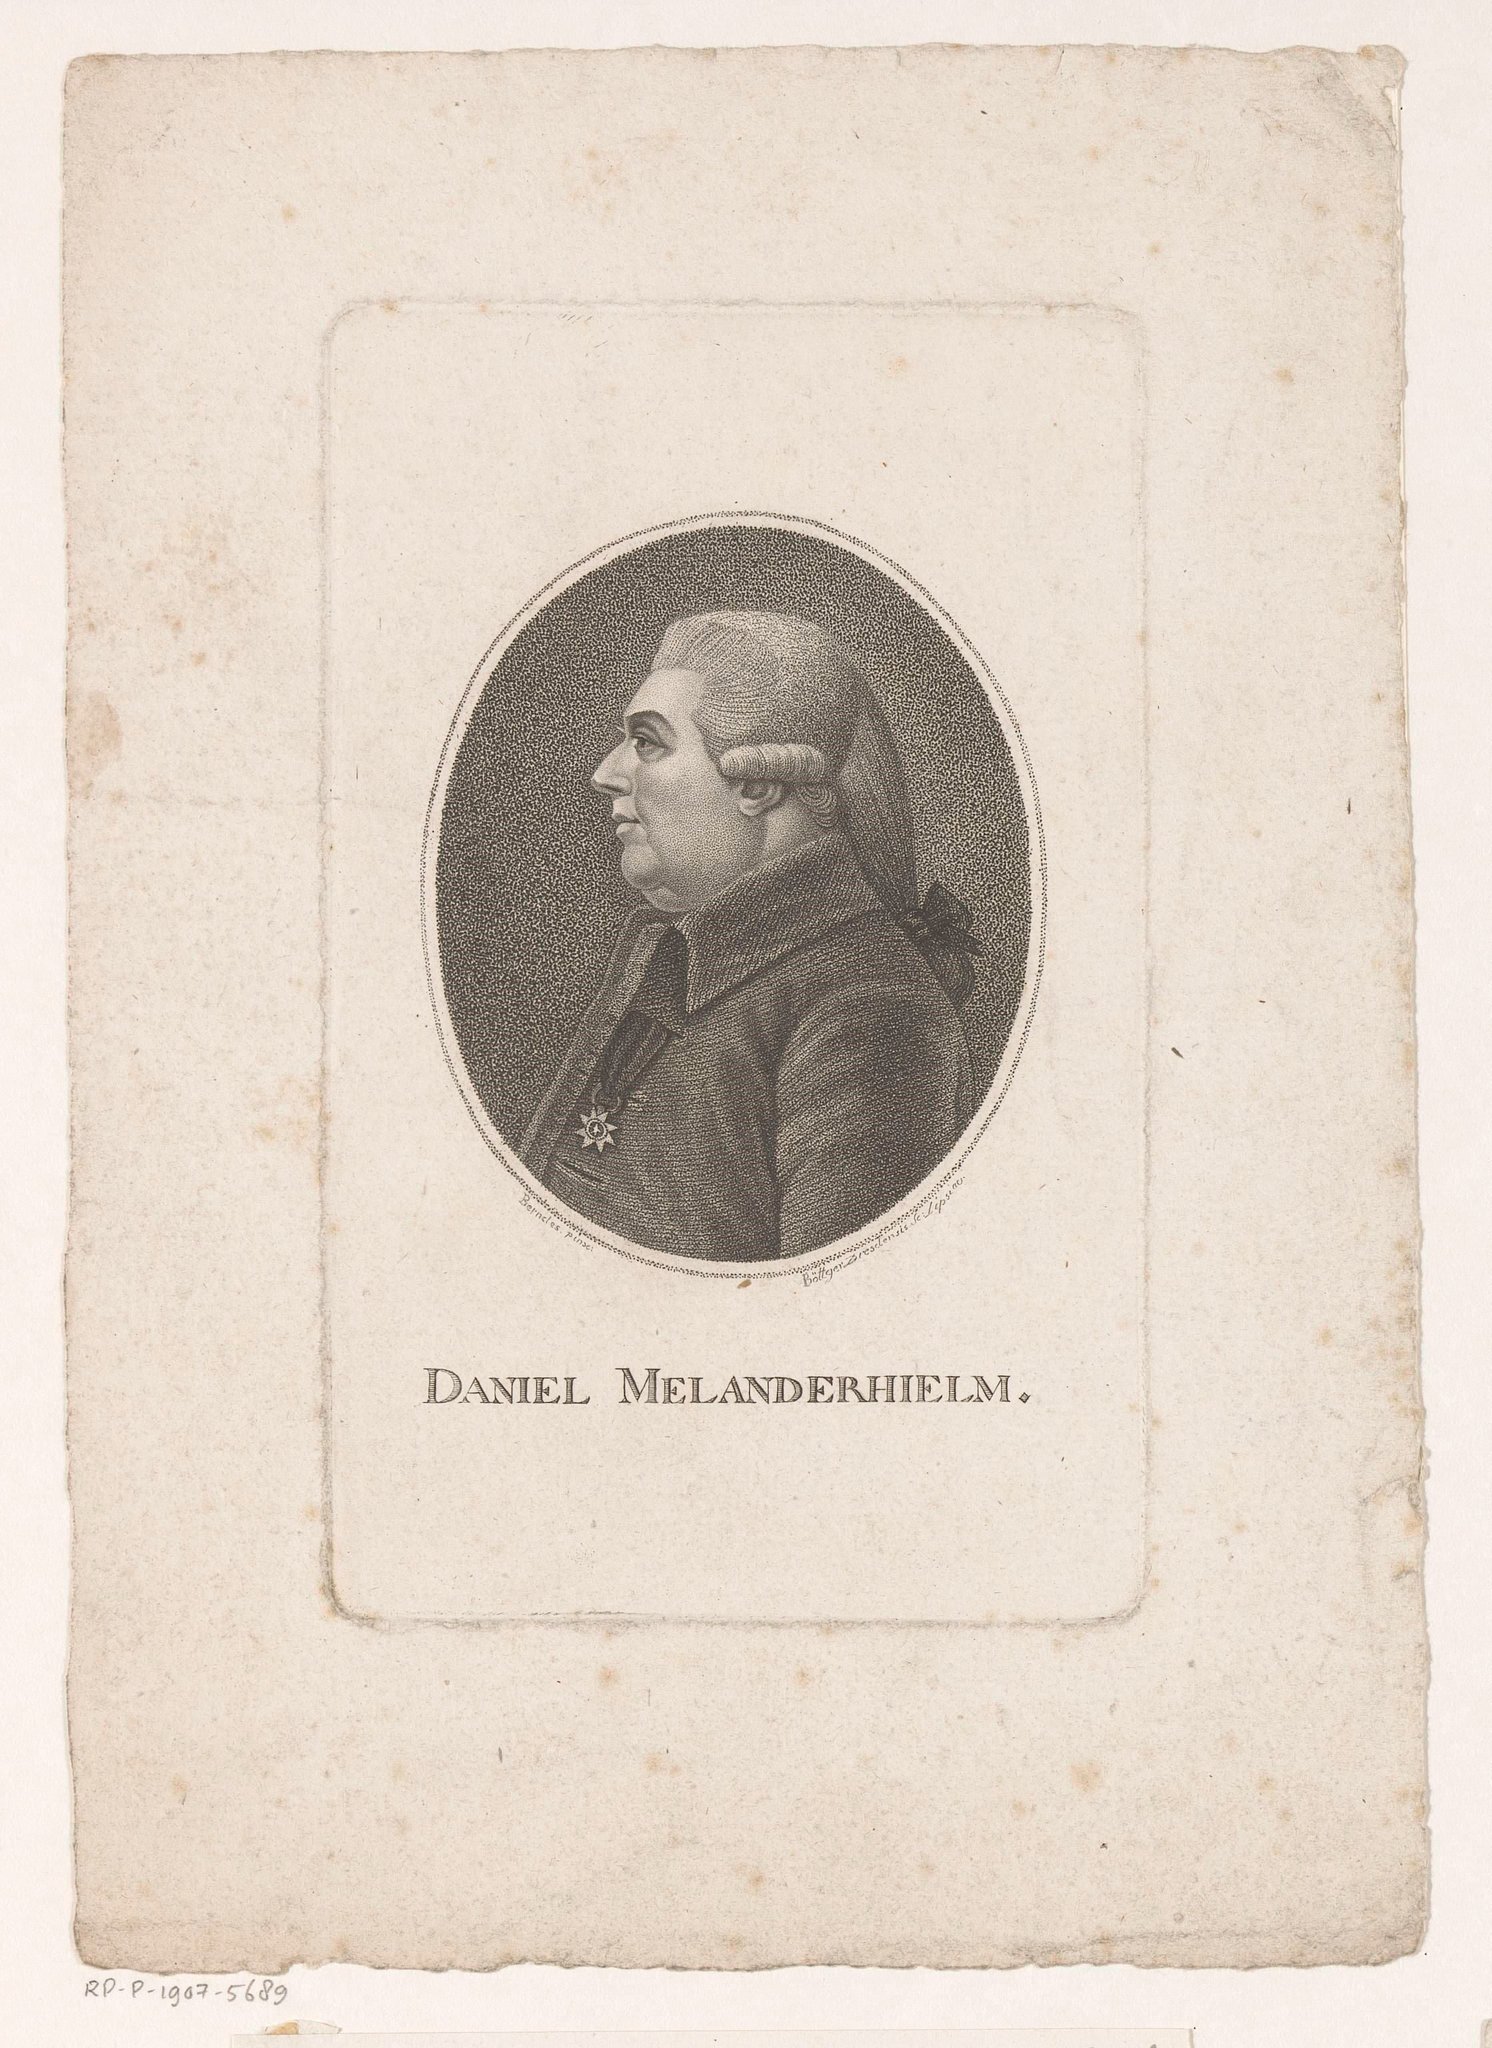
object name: print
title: Portret van Daniel Melander af Melanderhielm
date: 1796-1825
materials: paper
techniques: stippling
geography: leipzig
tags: historical persons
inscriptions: collector's mark: Lugt 2228